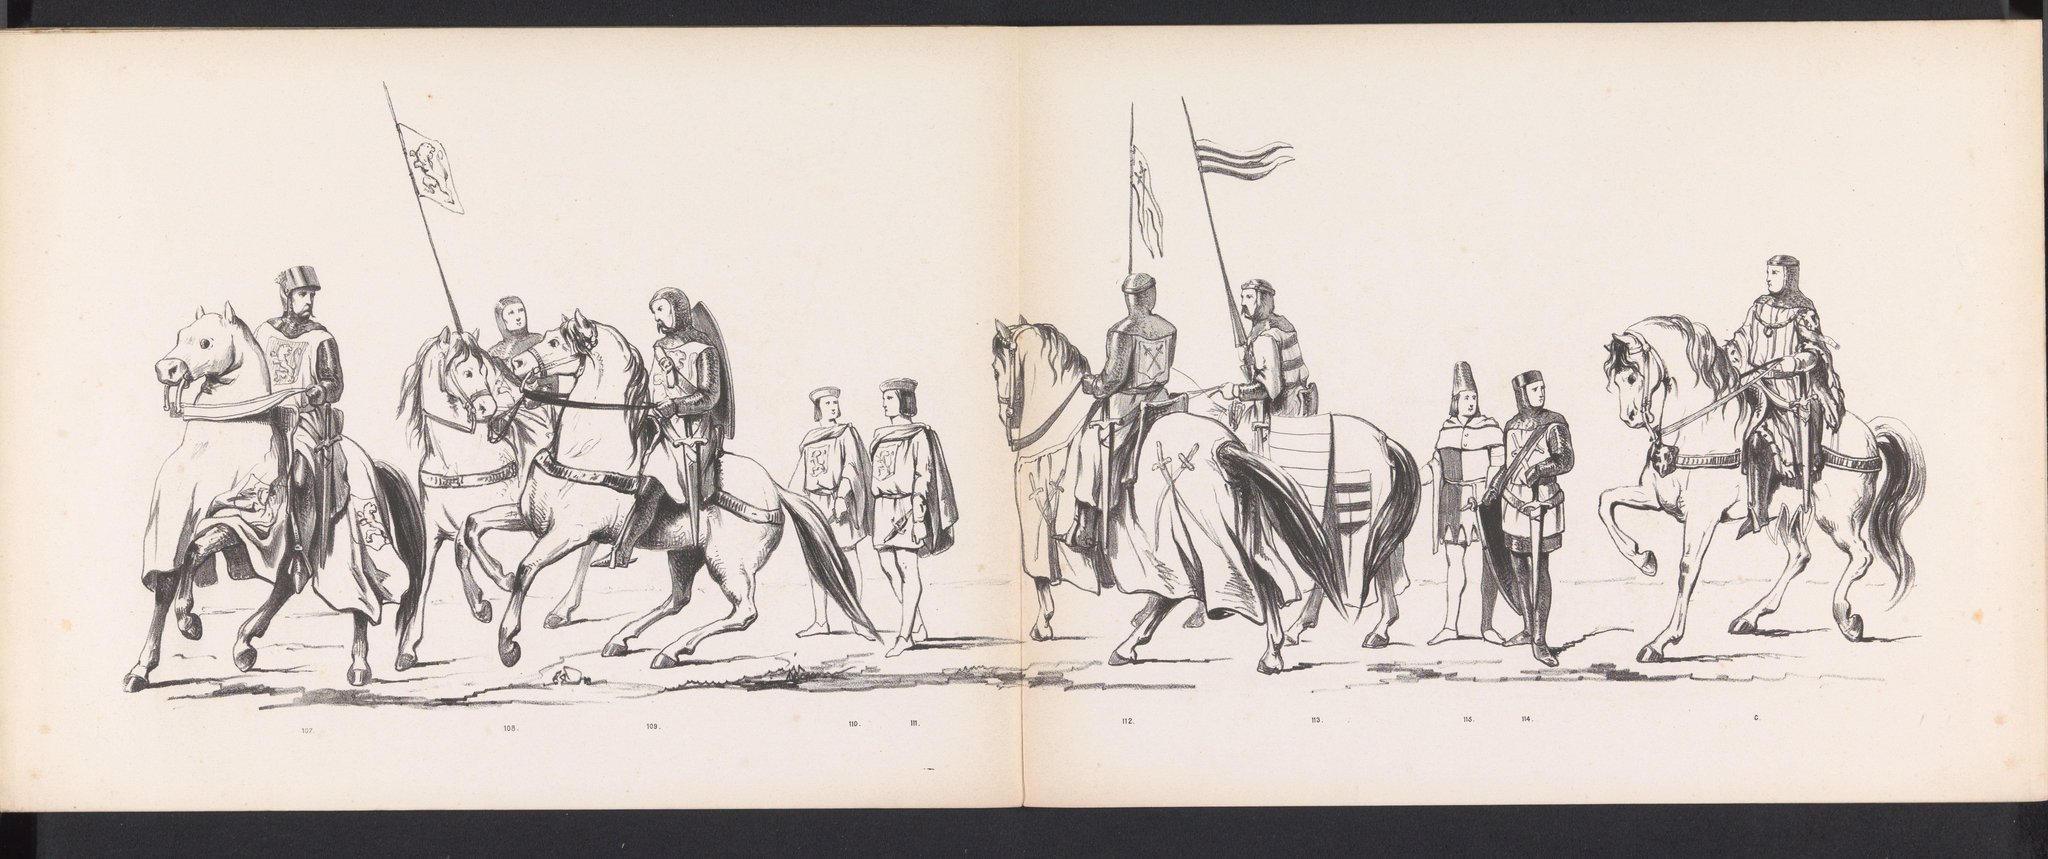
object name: print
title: Maskerade van de Leidse studenten, 1865 (plaat 9)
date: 1865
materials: paper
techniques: lithograph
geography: netherlands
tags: students' pageant, costumes used in pageants, leiden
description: Historische gekostumeerde optocht van de studenten van de Leidse Hogeschool gehouden op 6 juni 1865 ter gelegenheid van het 290-jarig bestaan van de Hogeschool. De optocht verbeeldt de intocht van de Hollanders binnen Zierikzee op 12 augustus 1304. Negende plaat met de groepen genummerd 107-114. Onderdeel van de serie van 16 aaneen geplakte bladen.